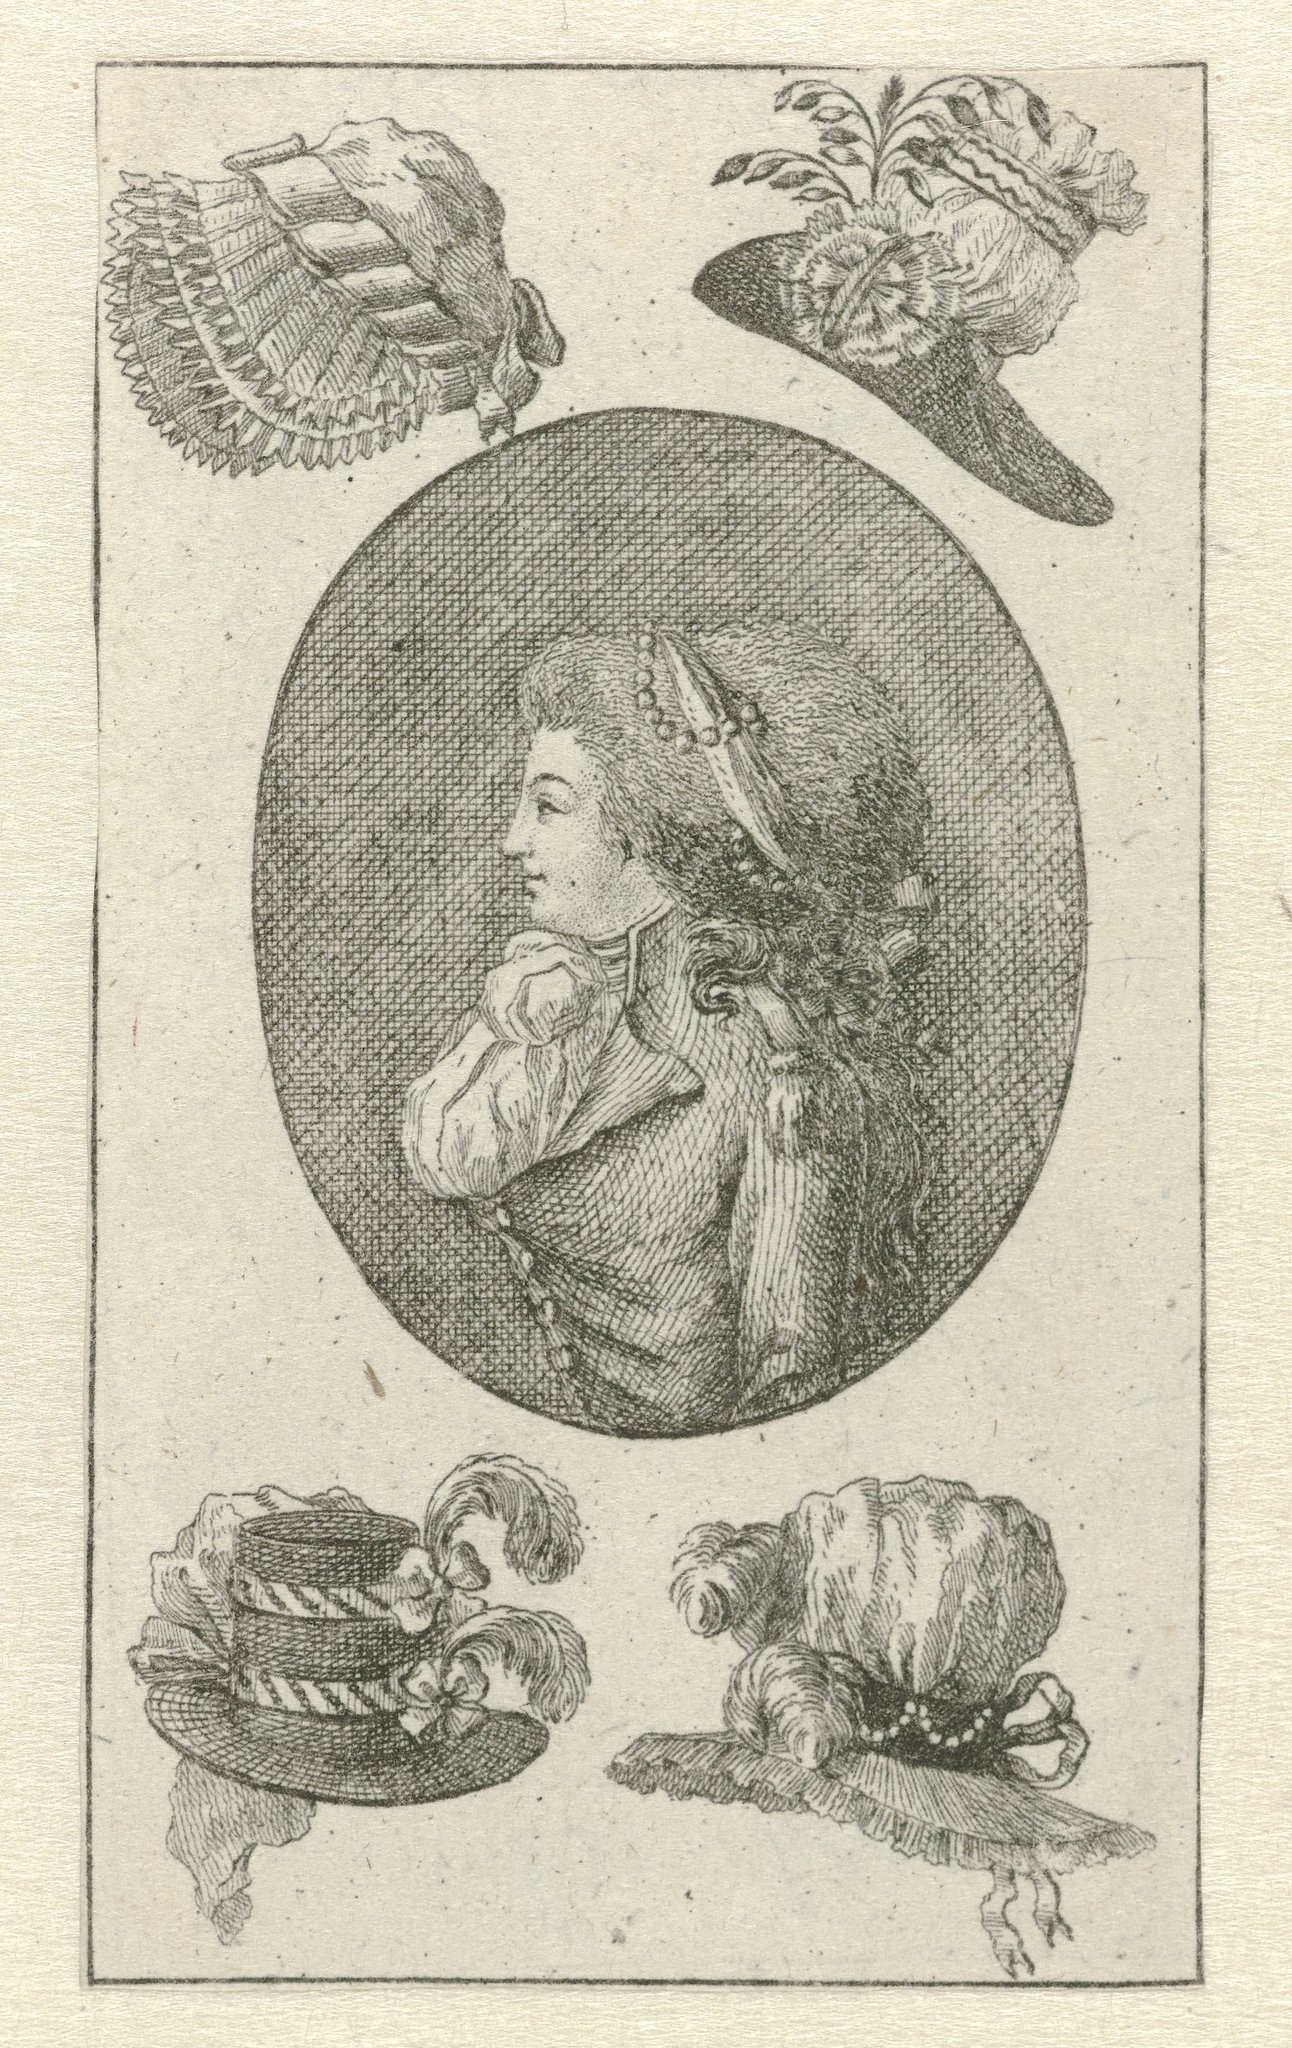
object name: almanac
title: Almanakprentje uit ca. 1787-'88.: Vrouwenbuste in ovaal waaromheen vier hoeden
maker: Anonymous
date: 1787-1788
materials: paper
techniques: engraving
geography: england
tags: clothing for the upper part of the body (+ women's clothes), calendar, almanac, head-gear (+ women's clothes), styles of hairdress - aa - ~ women, fashion plates, neck-gear ~ clothing (+ women's clothes)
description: Vrouwenbuste, en profil naar links, in ovaal, waaromheen vier verschillende hoeden of mutsen. De prent maakt waarschijnlijk deel uit van een almanak, ca. 1787-'88.